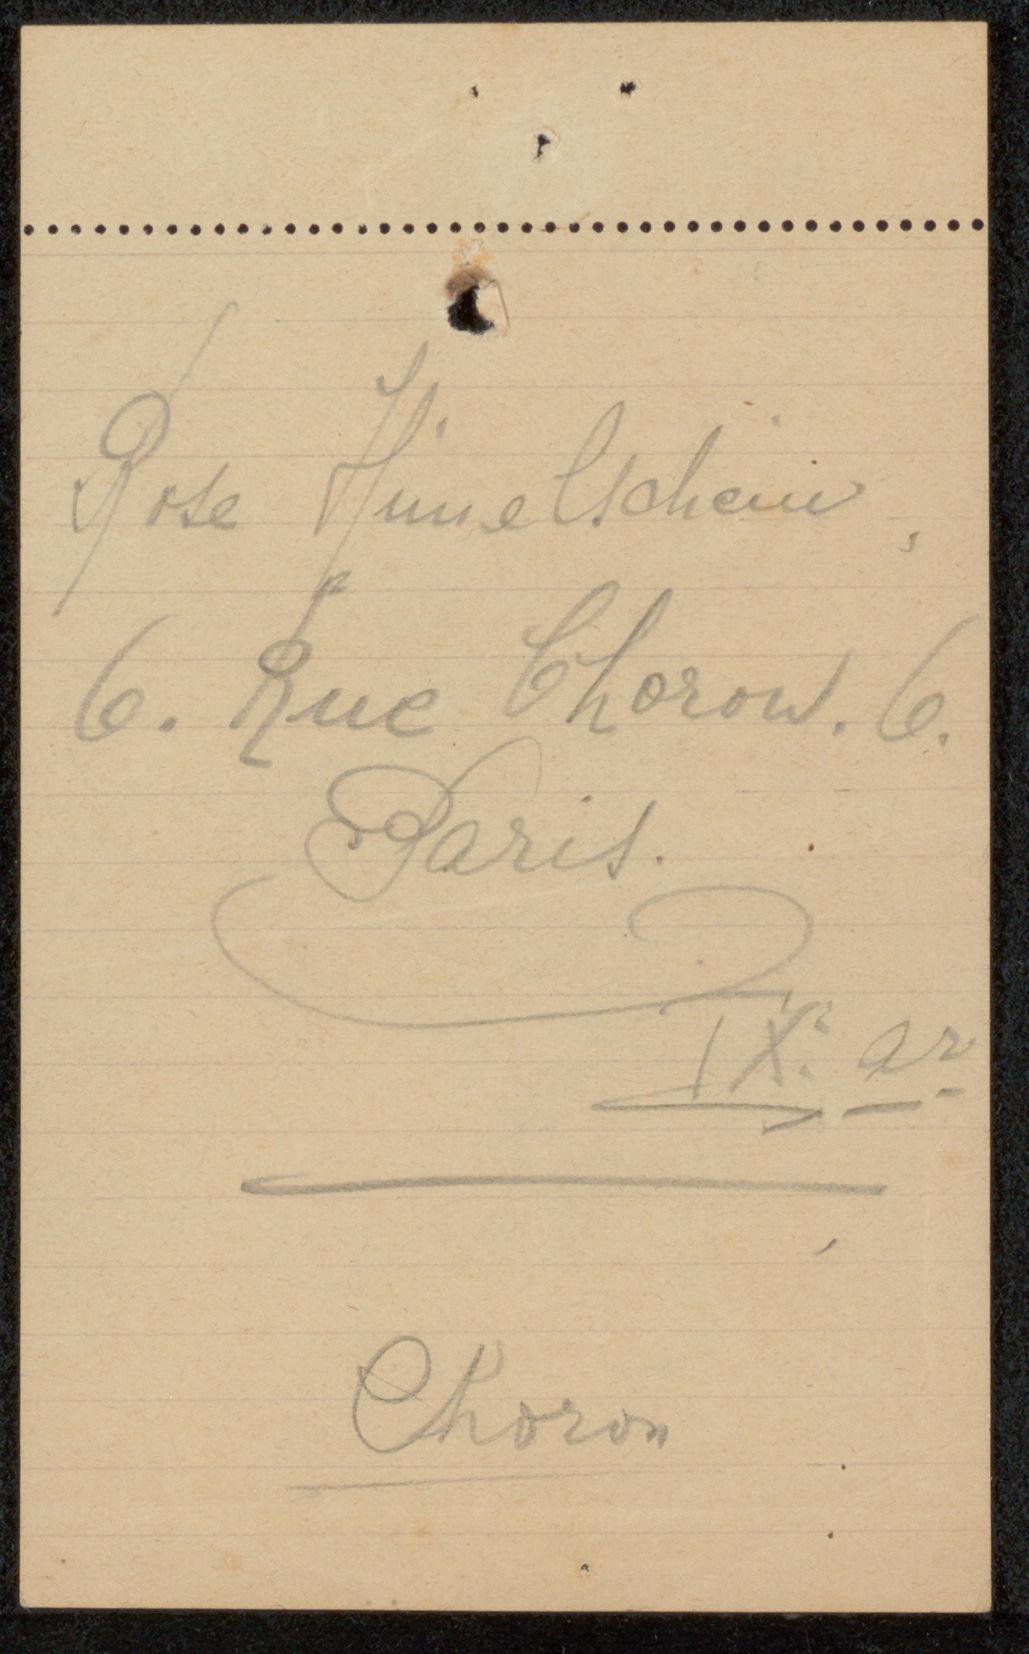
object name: aantekening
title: Aantekening aan Philip Zilcken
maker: rose imel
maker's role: draughtsman, painter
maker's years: 1901-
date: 1911-1930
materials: pencil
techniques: writing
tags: philip zilcken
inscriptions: collector's mark: ‘RPK’